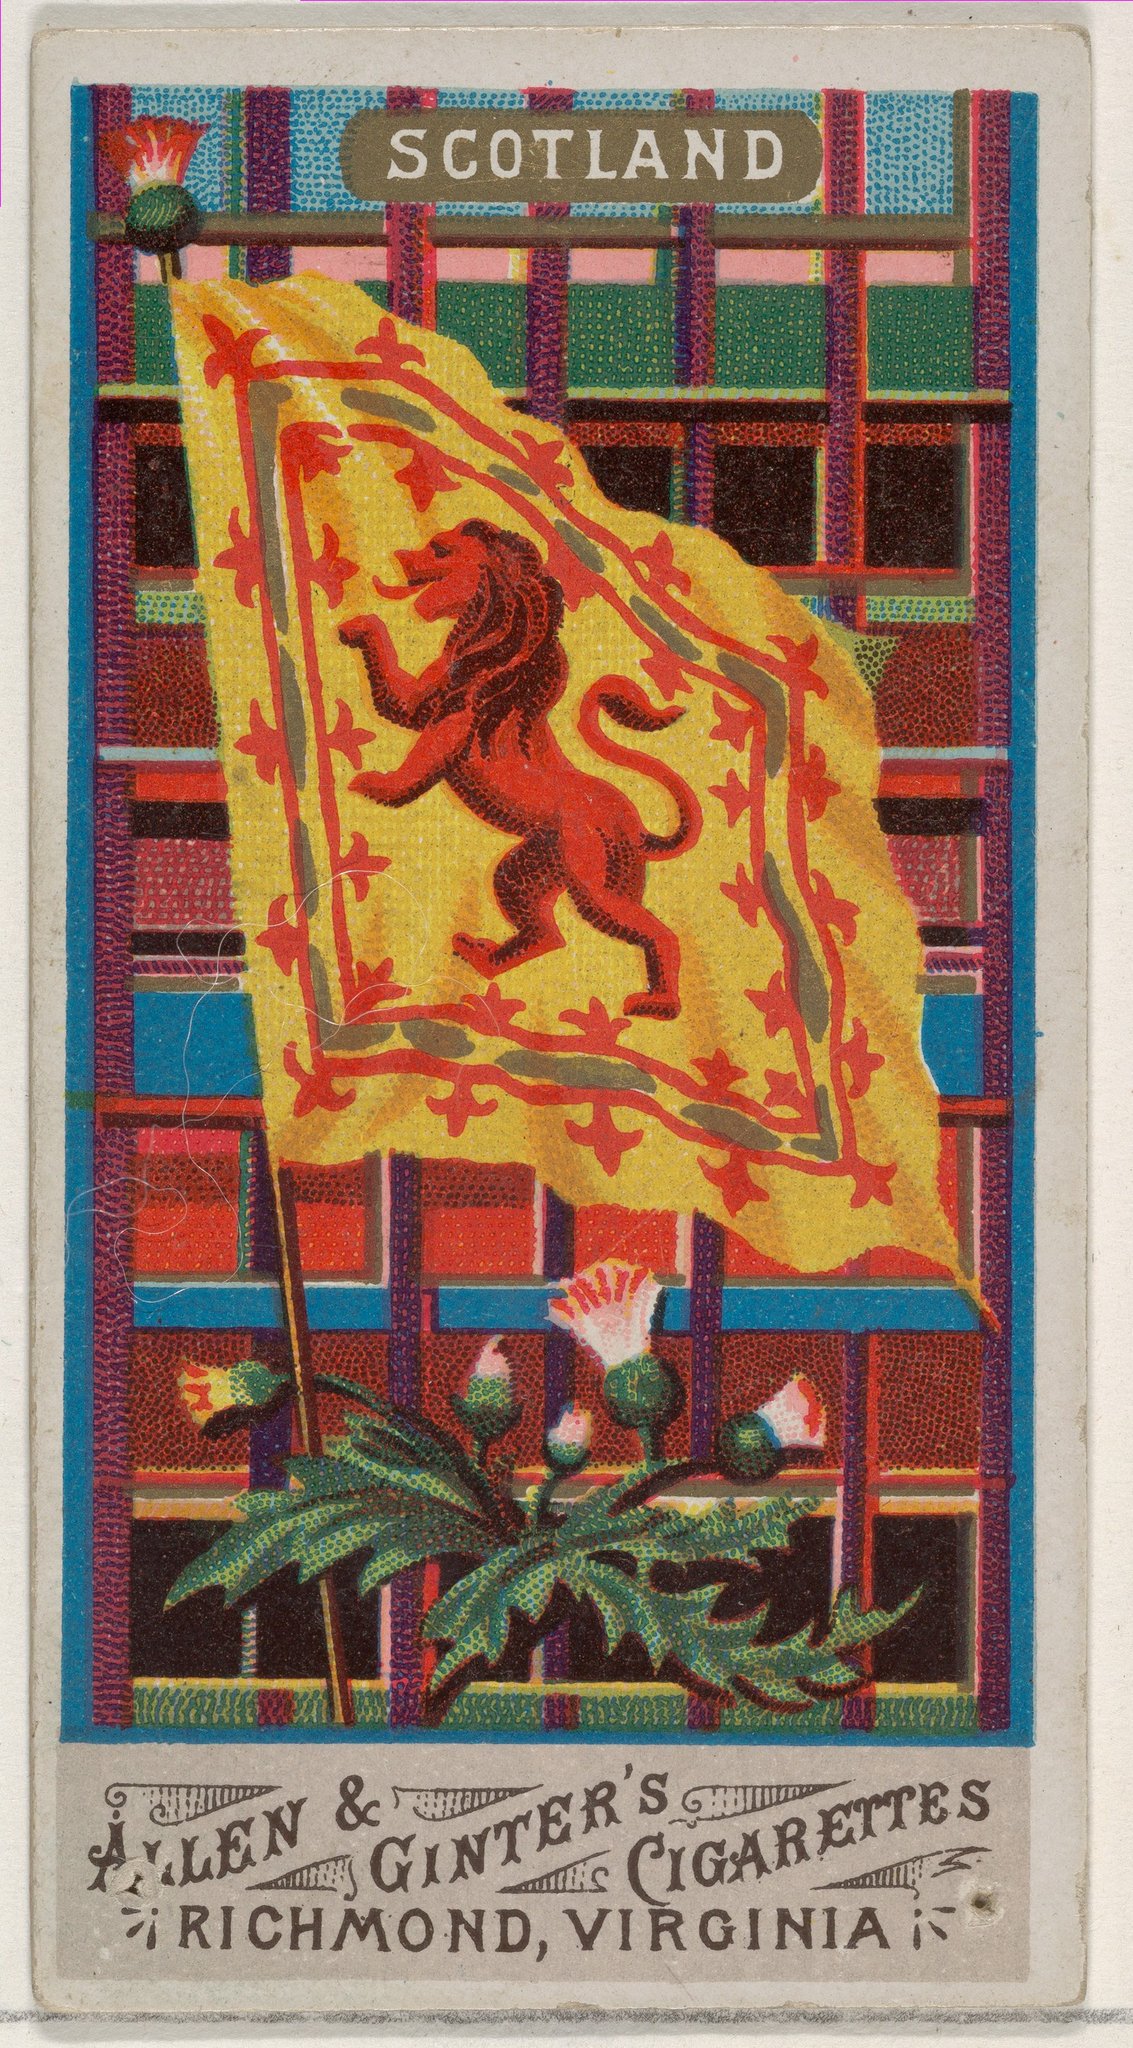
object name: print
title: Scotland, from Flags of All Nations, Series 1 (N9) for Allen & Ginter Cigarettes Brands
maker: allen & ginter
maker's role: publisher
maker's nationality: american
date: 1887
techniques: color lithograph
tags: lions,flags